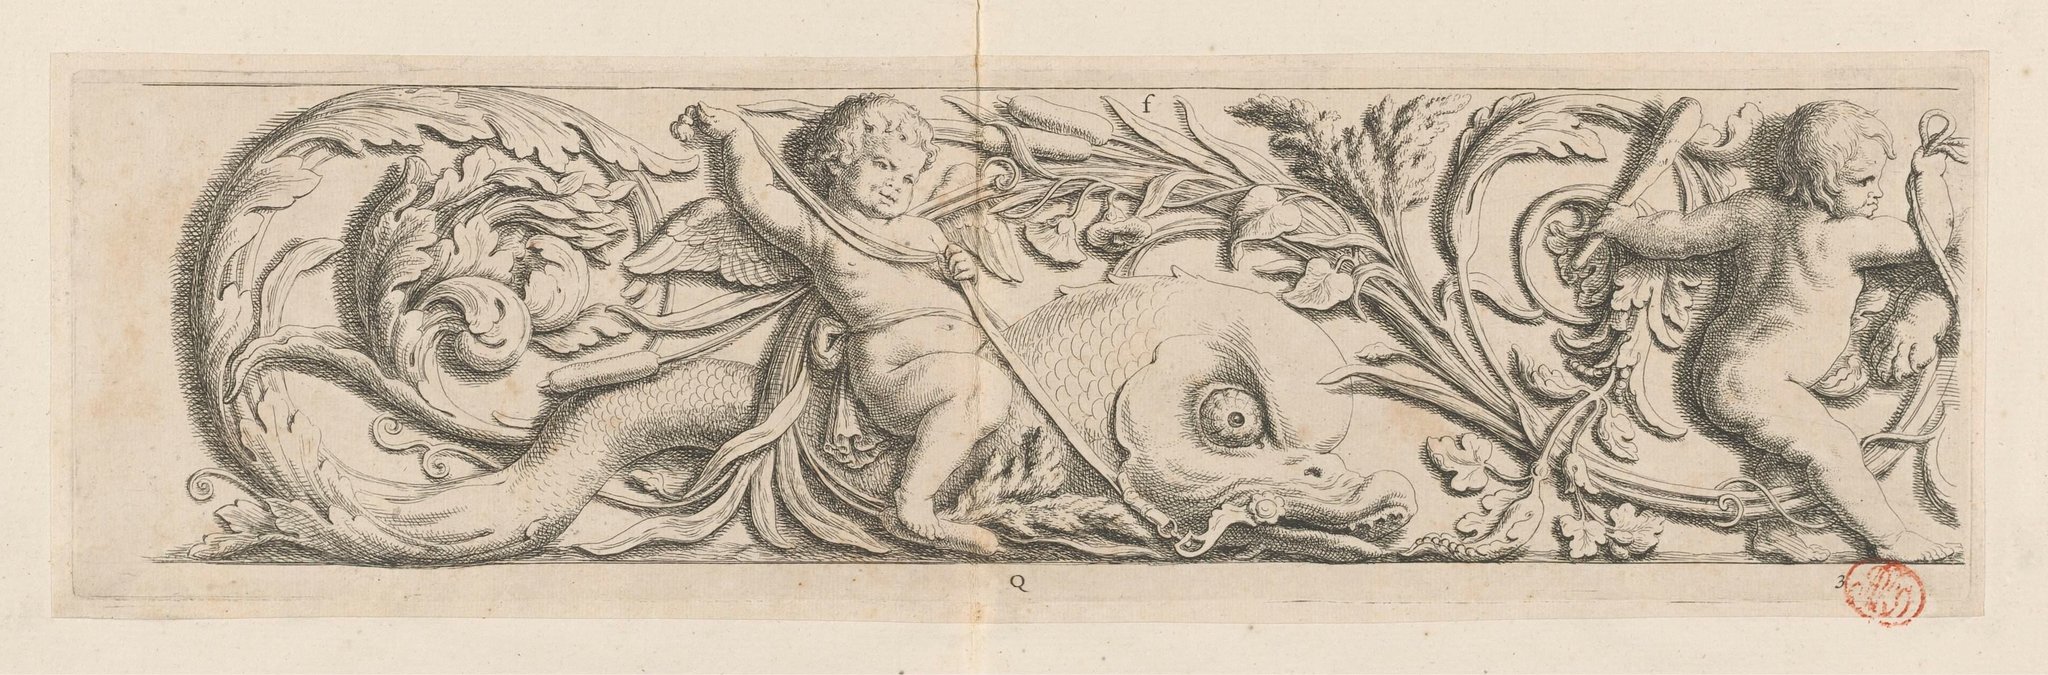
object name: book illustration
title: Deel van fries op schouw in Vroedschapskamer van het Stadhuis op de Dam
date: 1663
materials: paper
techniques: engraving, etching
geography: amsterdam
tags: dolphin ~ ornament, swimming mammals: dolphin, allegory, personification of good government, cupids: 'amores', 'amoretti', 'putti'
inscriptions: collector's mark: Lugt 195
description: Prent gebruikt in: Secunca pars Praecipuarum effigierum ac ornamentorum amplissime Curiae Amstelrodamensis maiori ex parte in cadido marmore effectorum per Artum Quellinium eiusdem Civitatis Statuarium / Het tweede deel Van de voornaemste Statuen ende Cieraten van 't konst-rijcke Stadt-huys van Amstelredam 'tmeeste in Marmer gemaeckt door Artus Quellinus Beelthouwer der voorseyde Stadt. Amsterdam: Artus Quellinus (I), 1663. Zie RP-P-AO-22-2-1 voor bijhorende titelpagina. Zie RP-P-AO-22-2-2 voor bijhorend register. Zie RP-P-AO-22-2A, RP-P-AO-22-2B, RP-P-AO-22-2C-1, RP-P-AO-22-2C-2, RP-P-AO-22-2C-3, RP-P-AO-22-2C-4, RP-P-AO-22-2D-1, RP-P-AO-22-2D-2, RP-P-AO-22-2D-3, RP-P-AO-22-2E-1, RP-P-AO-22-2E-2, RP-P-AO-22-2E-3, RP-P-AO-22-2E-4, RP-P-AO-22-2F-1, RP-P-AO-22-2F-2, RP-P-AO-22-2F-3, RP-P-AO-22-2G, RP-P-AO-22-2H, RP-P-AO-22-2I, RP-P-AO-22-2K, RP-P-AO-22-2L, RP-P-AO-22-2M, RP-P-AO-22-2N, RP-P-AO-22-2O-1, RP-P-AO-22-2O-2, RP-P-AO-22-2O-3, RP-P-AO-22-2O-4, RP-P-AO-22-2O-5, RP-P-AO-22-2O-6, RP-P-AO-22-2O-7, RP-P-AO-22-2P-1, RP-P-AO-22-2P-2, RP-P-AO-22-2Q-1, RP-P-AO-22-2Q-2, RP-P-AO-22-2R-1, RP-P-AO-22-2R-2, RP-P-AO-22-2R-3, RP-P-AO-22-2S, RP-P-AO-22-2T-1, RP-P-AO-22-2T-2, RP-P-AO-22-2T-3, RP-P-AO-22-2T-4, RP-P-AO-22-2V-1, RP-P-AO-22-2V-2, RP-P-AO-22-2W-1, RP-P-AO-22-2W-2, RP-P-AO-22-2X-1, RP-P-AO-22-2X-2 en RP-P-AO-22-2X-3 voor andere prenten uit deze publicatie. Zelfde staat van prent ook gebruikt in: Secunca pars Praecipuarum effigierum ac ornamentorum amplissime Curiae Amstelrodamensis maiori ex parte in cadido marmore effectorum per Artum Quellinium eiusdem Civitatis Statuarium / Het tweede deel Van de voornaemste Statuen ende Cieraten van 't konst-rijcke Stadt-huys van Amstelredam 'tmeeste in Marmer gemaeckt door Artus Quellinus Beelthouwer der voorseyde Stadt. Amsterdam: Frederik de Wit, 1668. Latere staat van prent ook gebruikt in: Architecture peinture et sculpture de la Maison de Ville d'Amsterdam, representee en CIX. figures en taille-douce (…). Amsterdam: David Mortier, 1719. En in: Architecture peinture et sculpture de la Maison de Ville d'Amsterdam, representee en CIX. figures en taille-douce (…). Amsterdam: Gerard Valck, 1719. En in: Bouw schilder en beeldhouwkonst, van het Stadhuis te Amsteldam, vertoont in CIX figuuren (…). Amsterdam: Covens & Mortier & Covens Jr., s.a. (1774-1783).